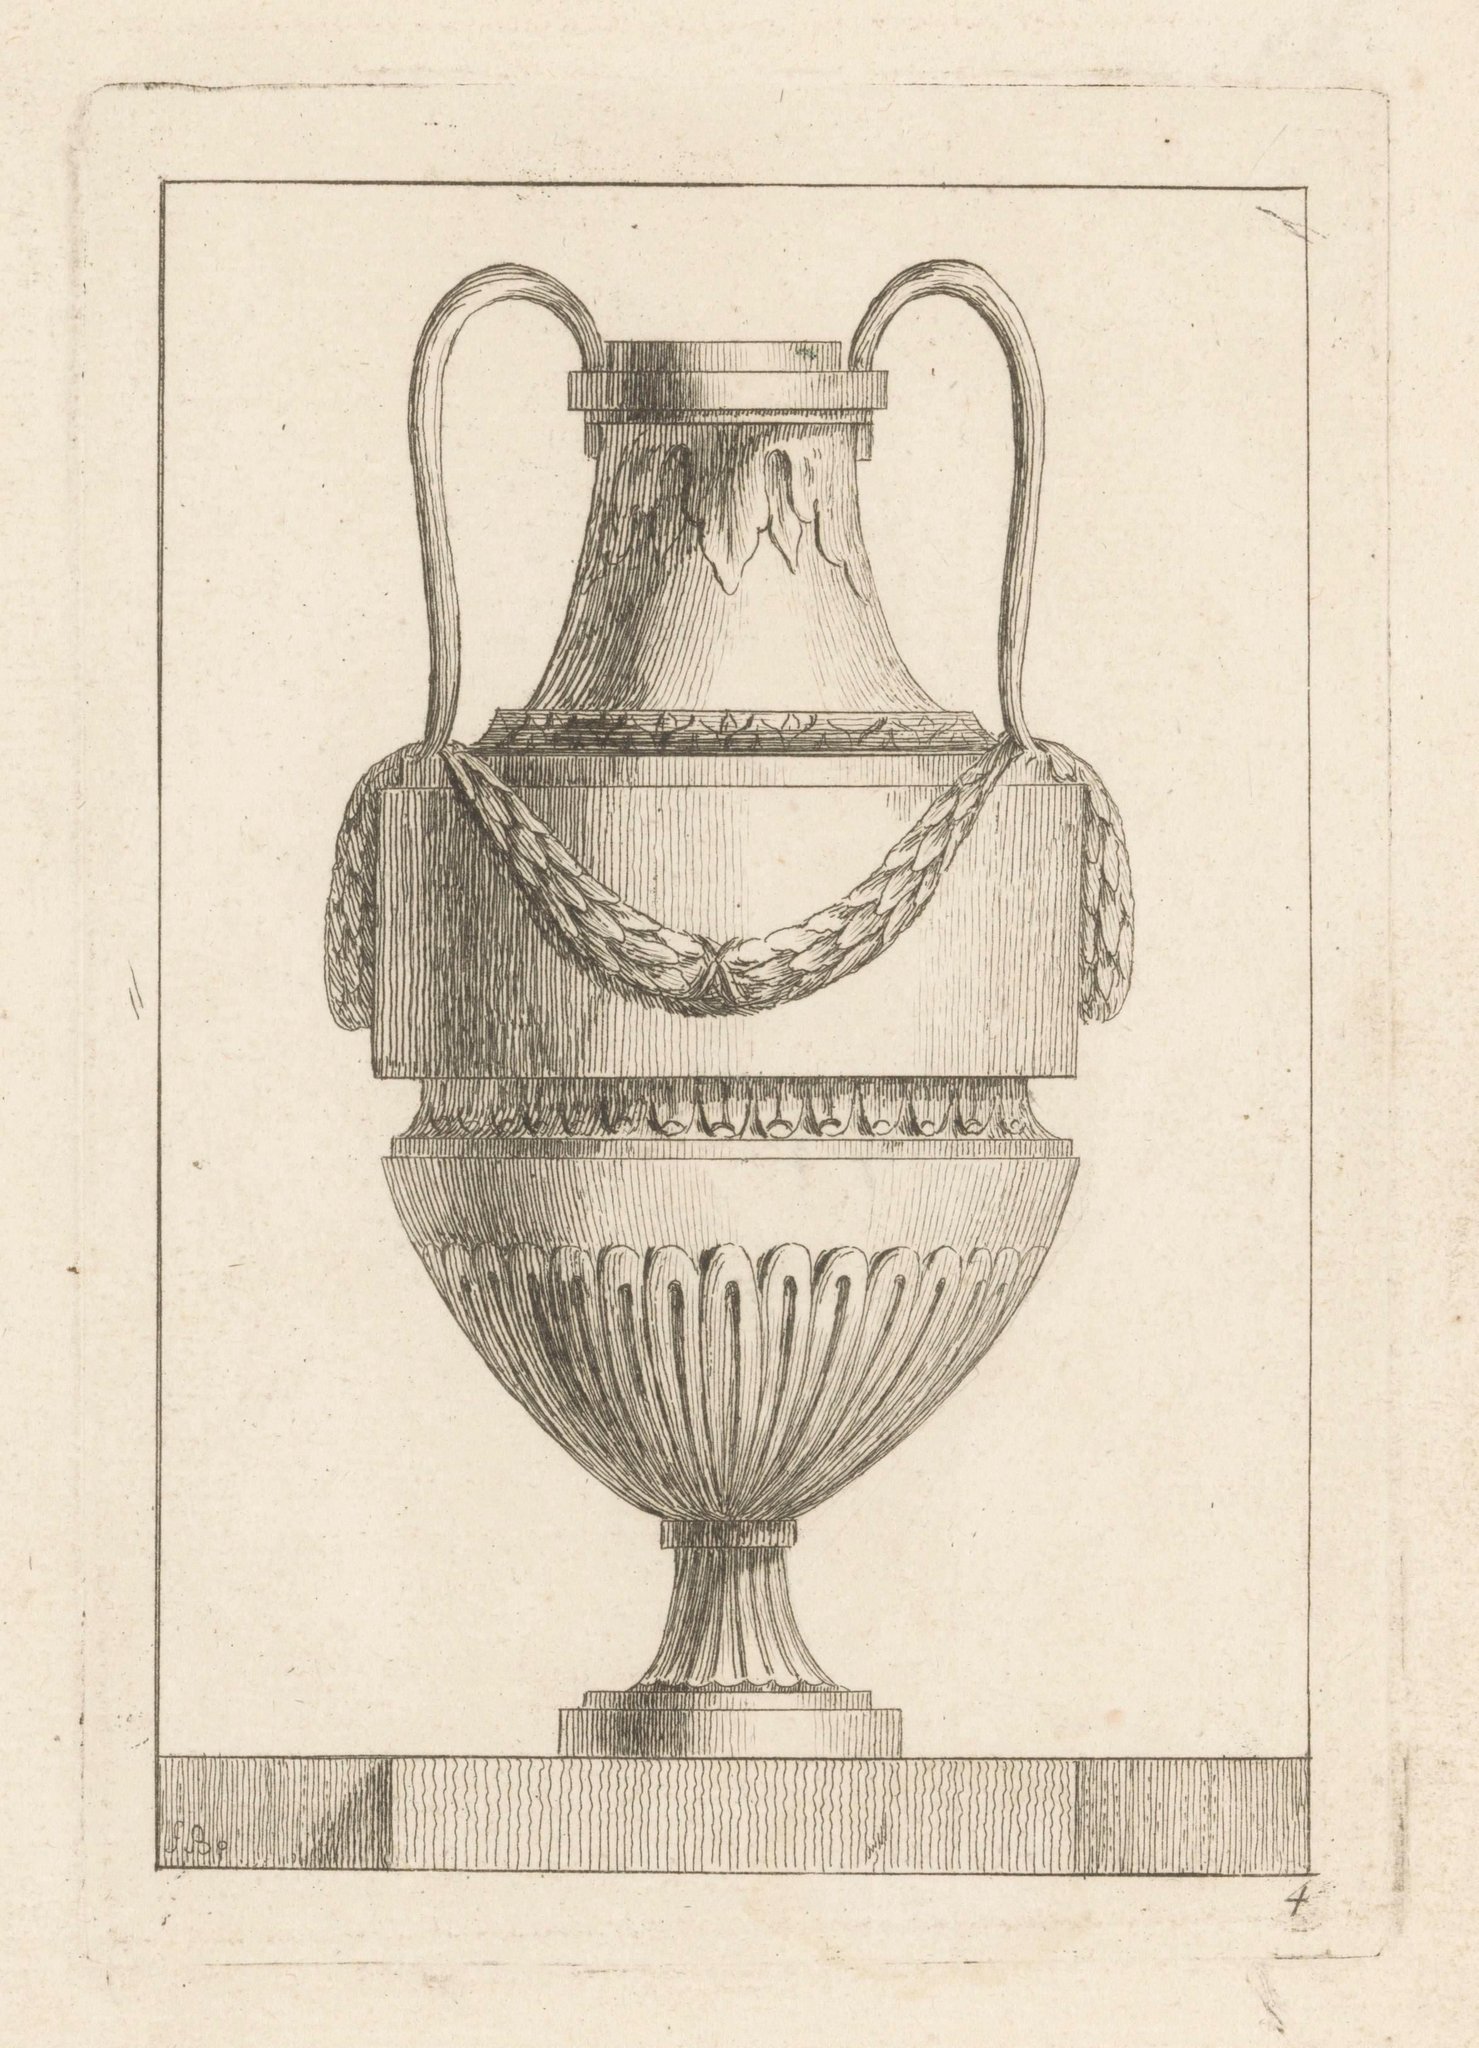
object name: ornament print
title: Vaas met guirlande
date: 1755-1782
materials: paper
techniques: etching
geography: paris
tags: vase ~ ornament, ornament ~ festoon, garland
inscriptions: collector's mark: Lugt 2228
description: Een vaas met guirlande over de buik en twee ranke oren.